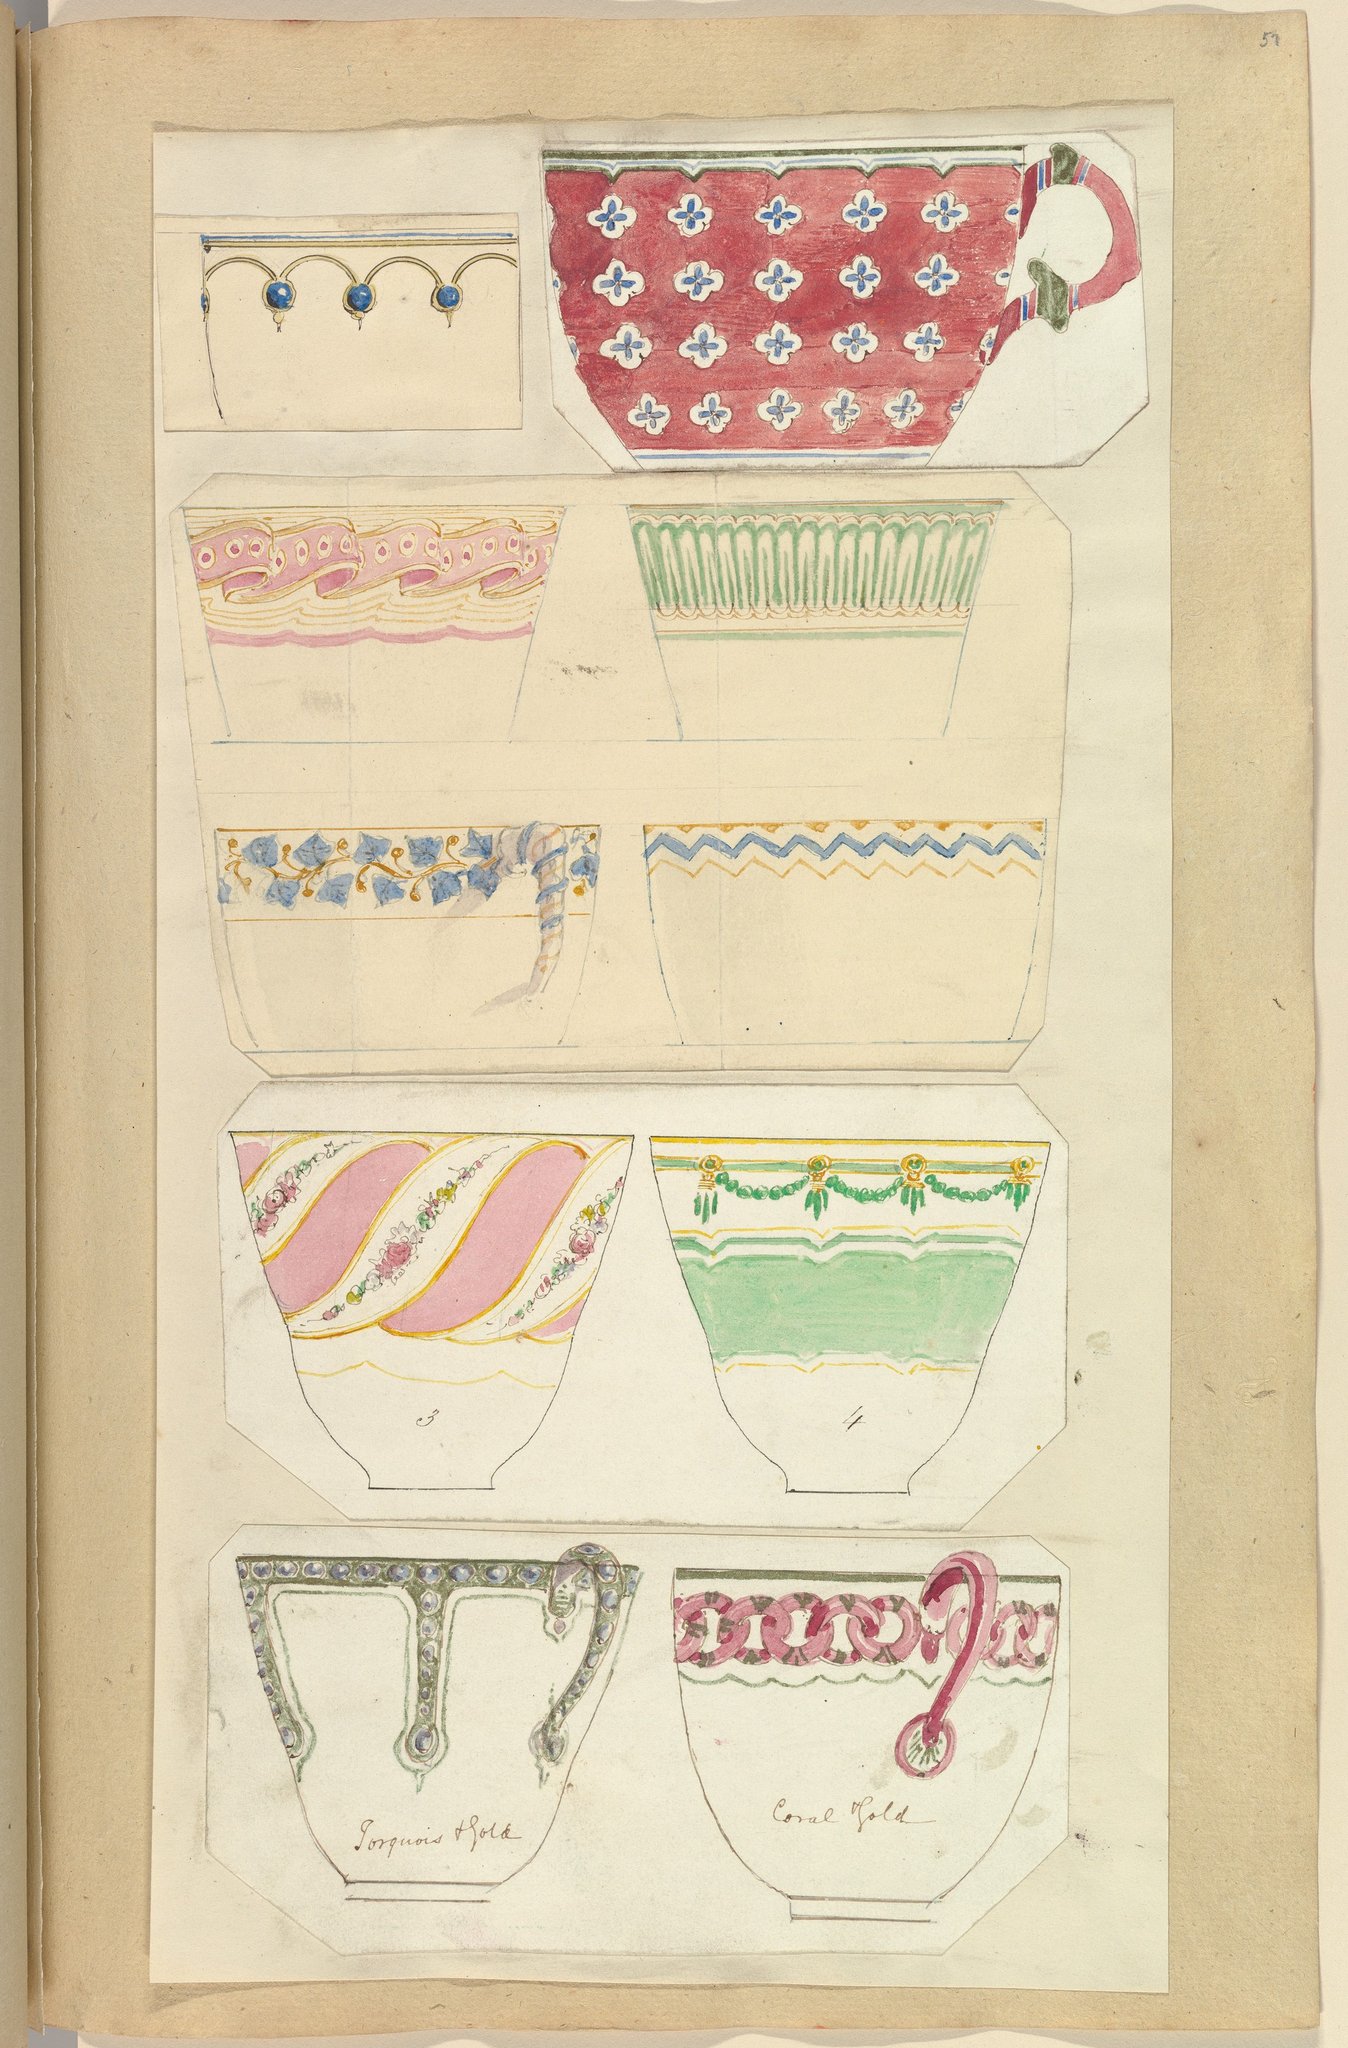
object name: drawing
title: Ten Designs for Decorated Cups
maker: alfred henry forrester [alfred crowquill]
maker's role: artist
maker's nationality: british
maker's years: 1804-1872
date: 1845-1855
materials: ink, watercolor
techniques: pen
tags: cups